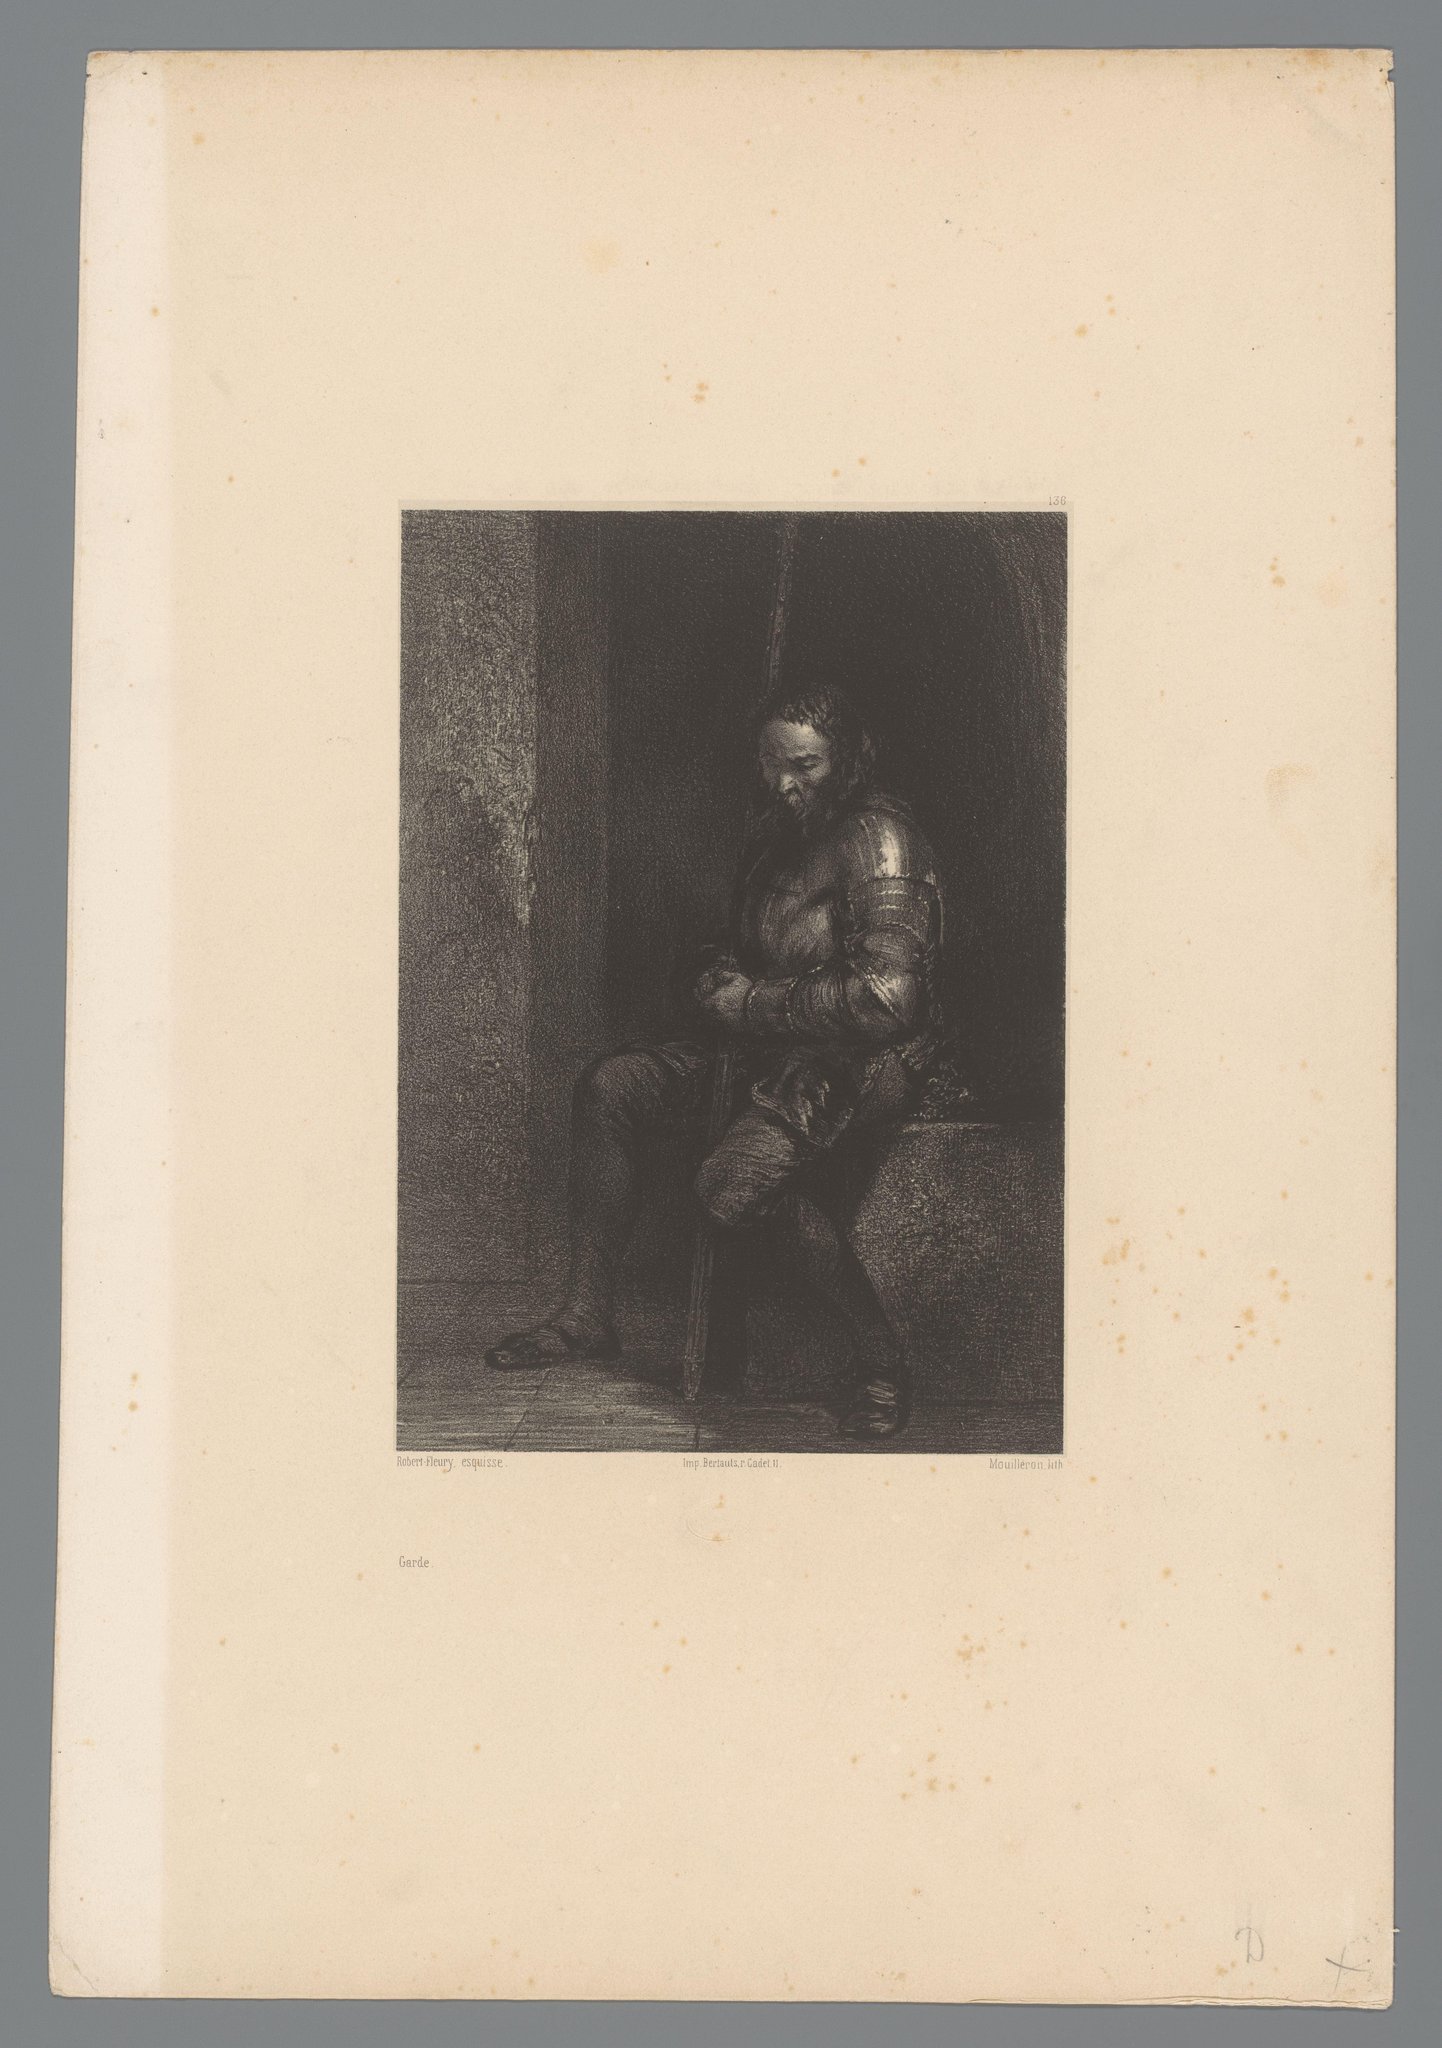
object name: print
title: Oude en hedendaagse kunstenaars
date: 1851-1862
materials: paper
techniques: lithograph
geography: paris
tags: guard duty, keeping sentry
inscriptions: collector's mark: Lugt 2233, check stamp: Lugt 36a, inscription: ‘Aug Allebé’